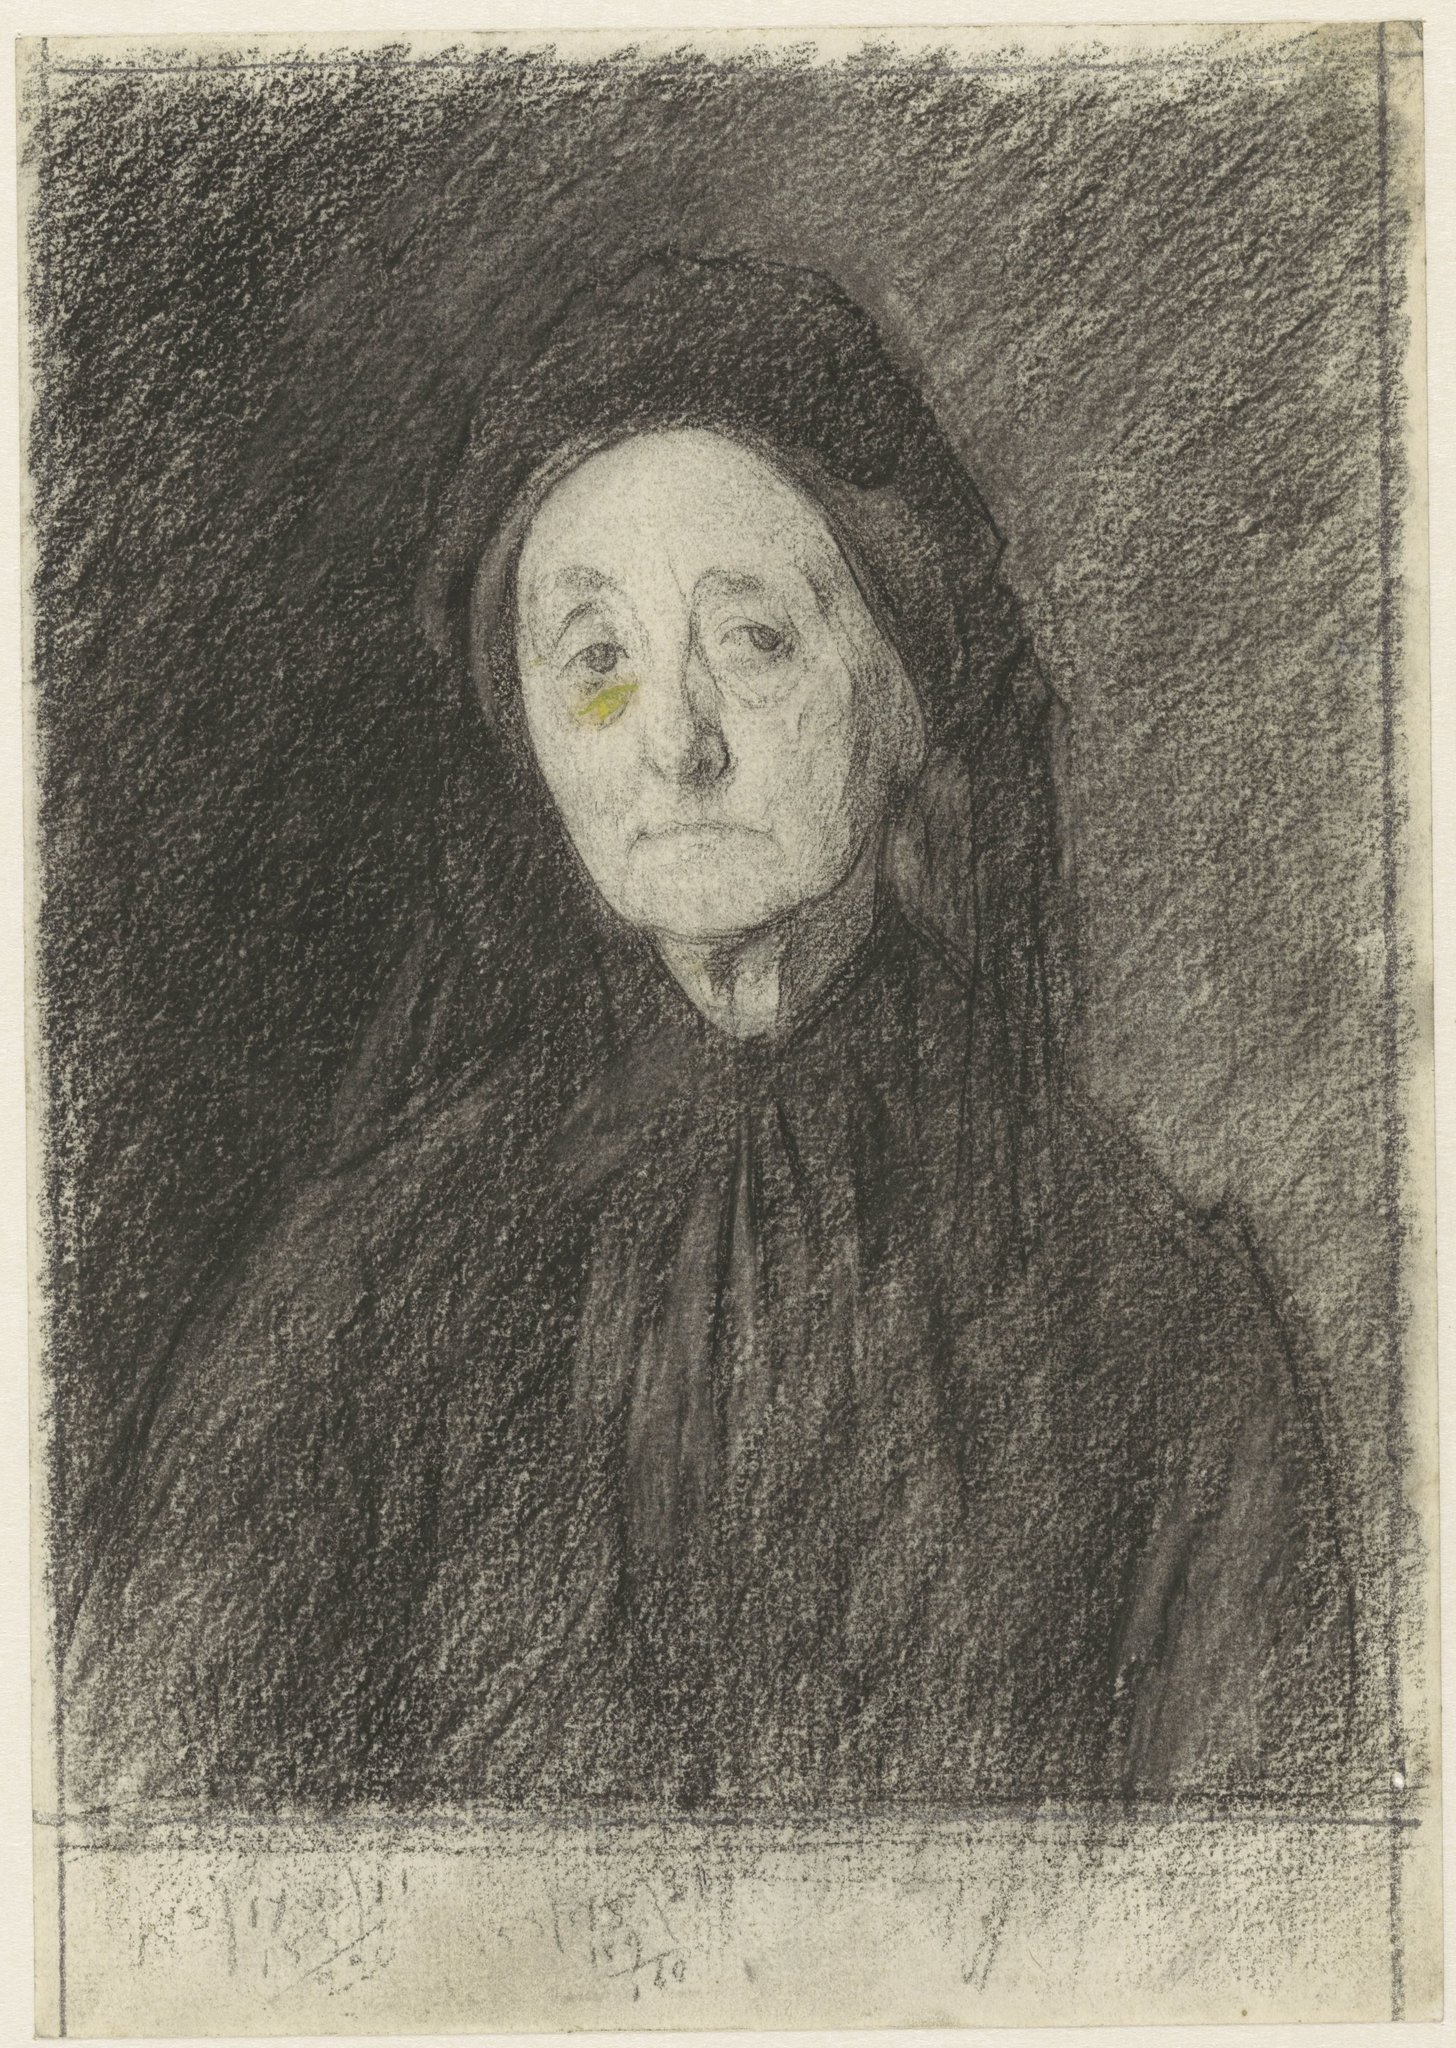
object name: drawing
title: Portret van mevrouw J.H. Giltay-Moll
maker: jan veth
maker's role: designer, draughtsman, painter, print maker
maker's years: 1864-1925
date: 1874-1925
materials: chalk, paper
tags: historical persons